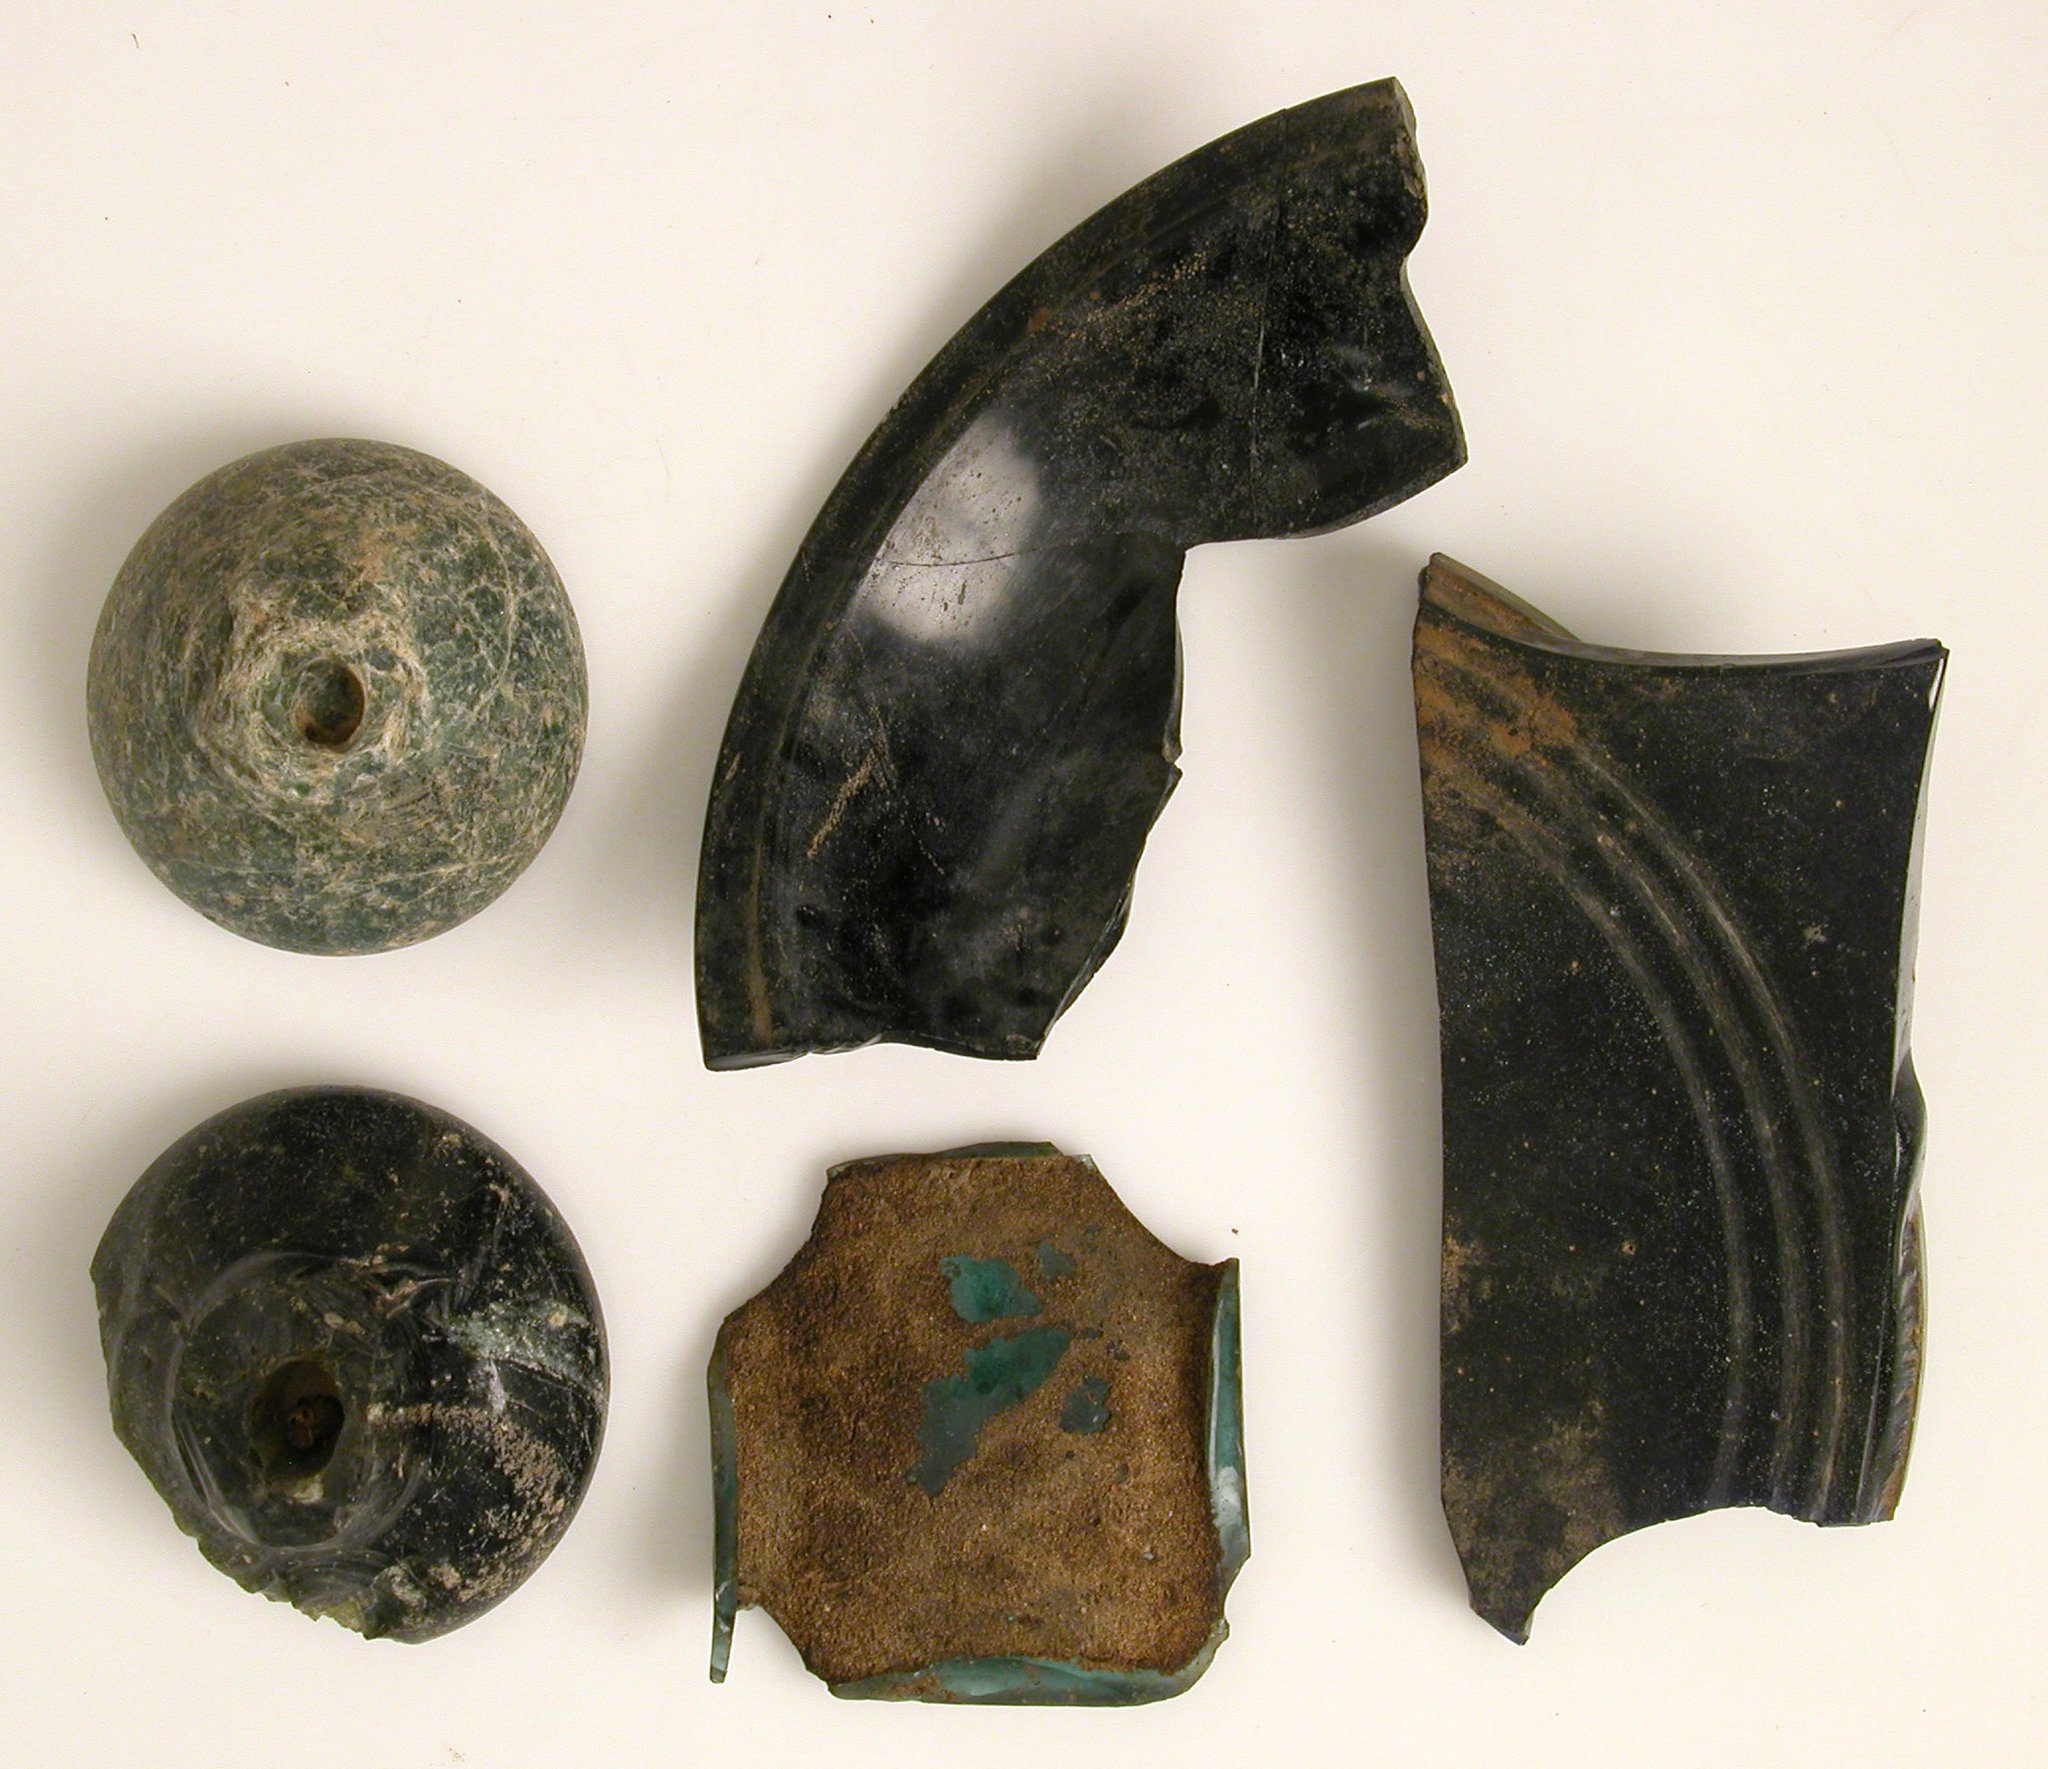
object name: fragment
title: Glass Fragments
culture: coptic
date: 301-700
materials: glass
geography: egypt